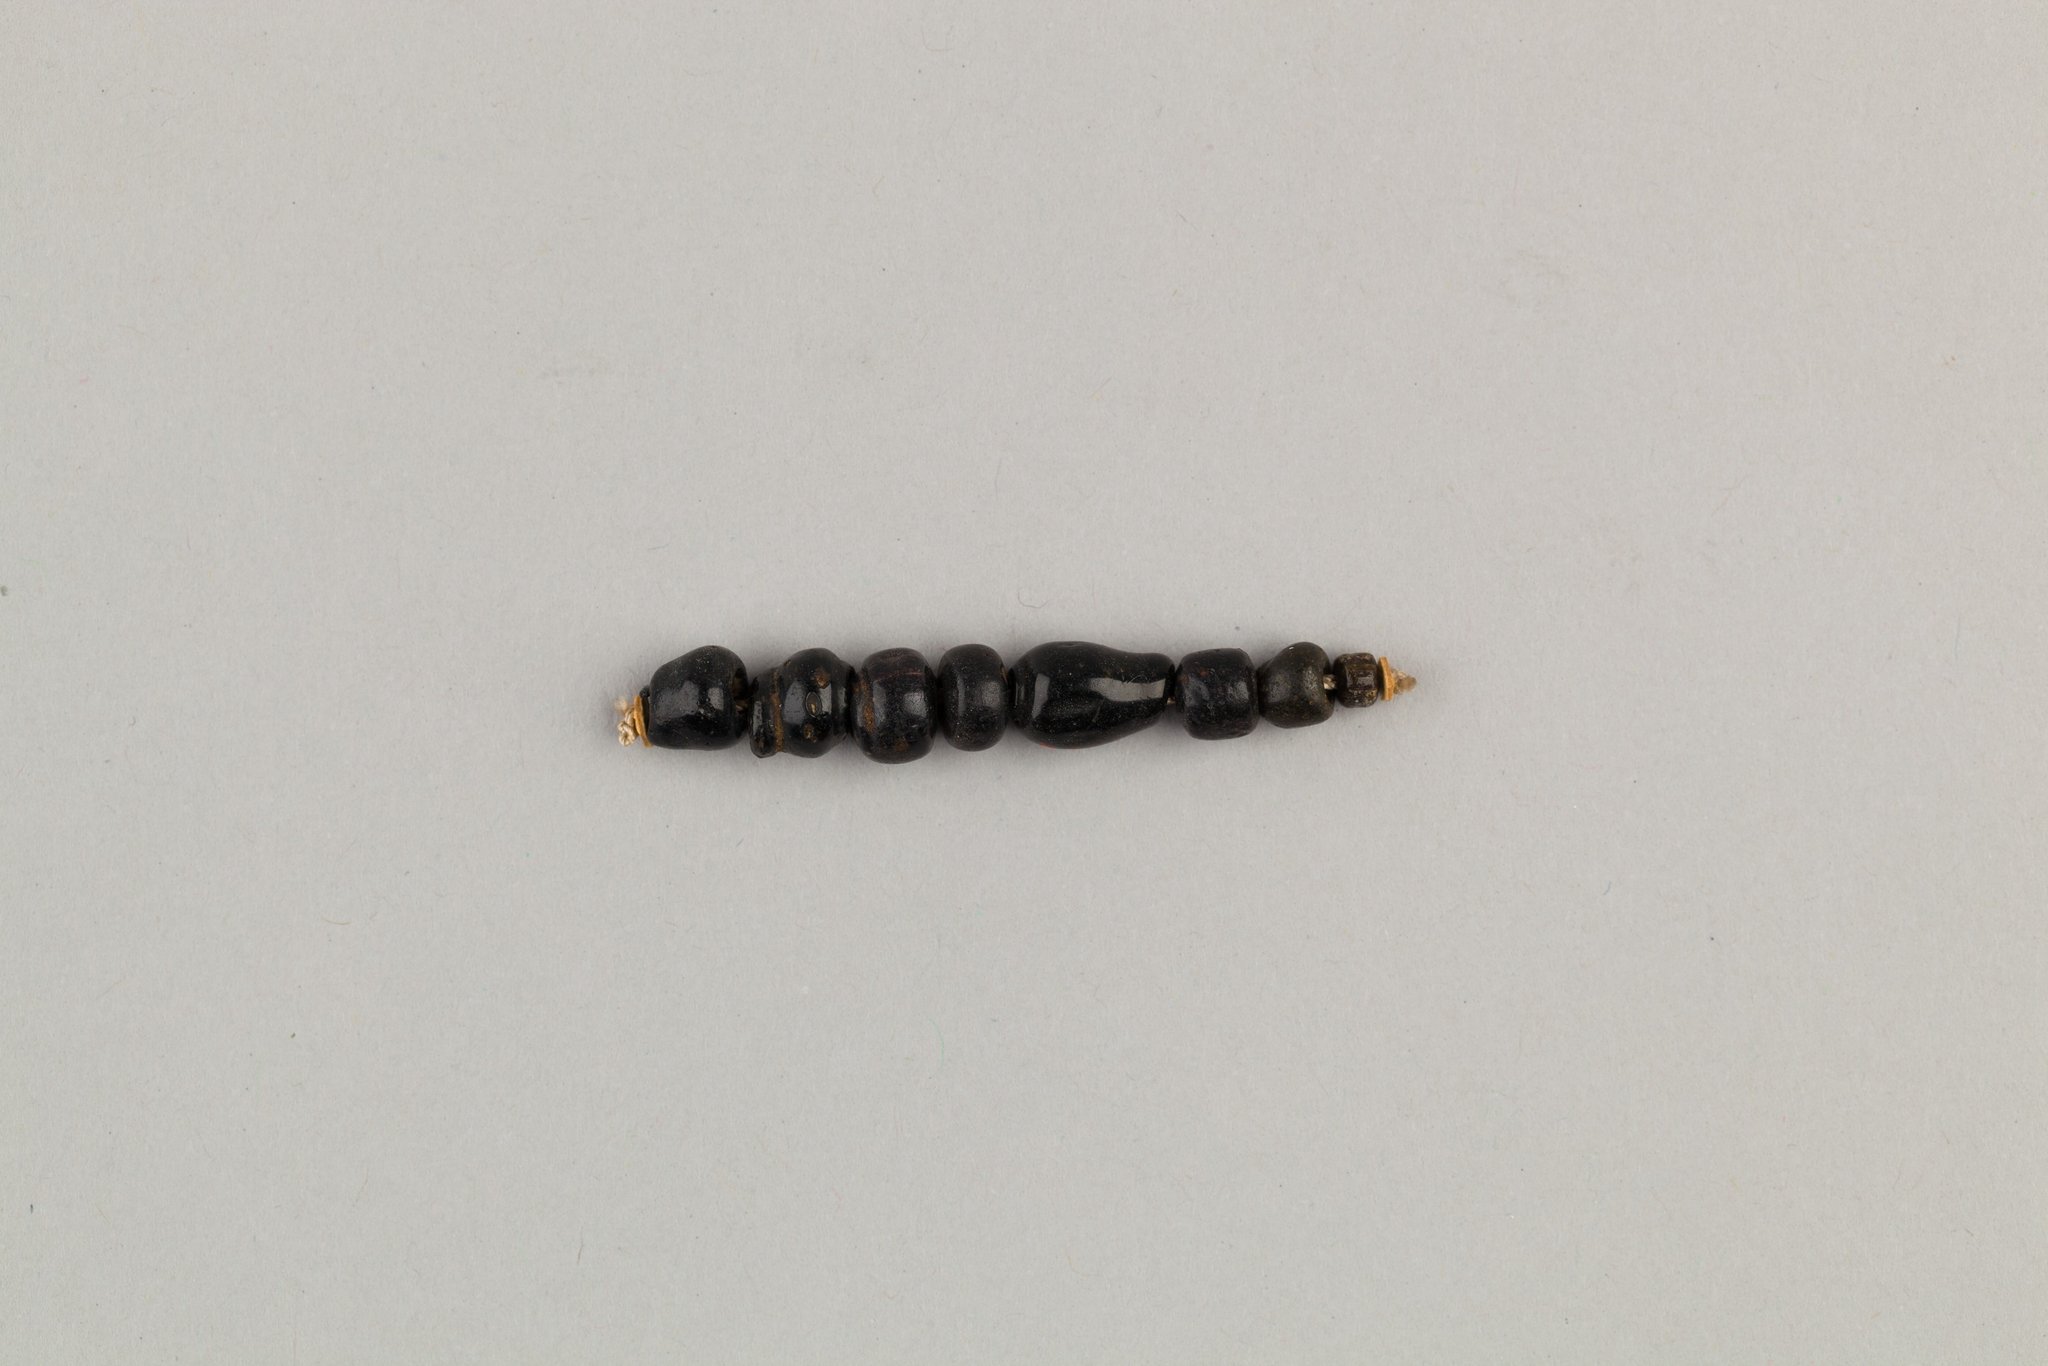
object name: bead, string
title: String of 8 beads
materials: glass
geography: egypt